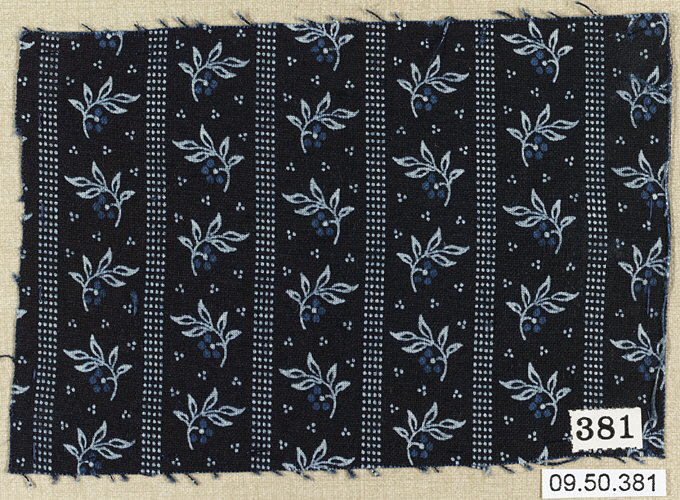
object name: piece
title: Piece (one of 116)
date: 1801-1900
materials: cotton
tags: flowers,leaves